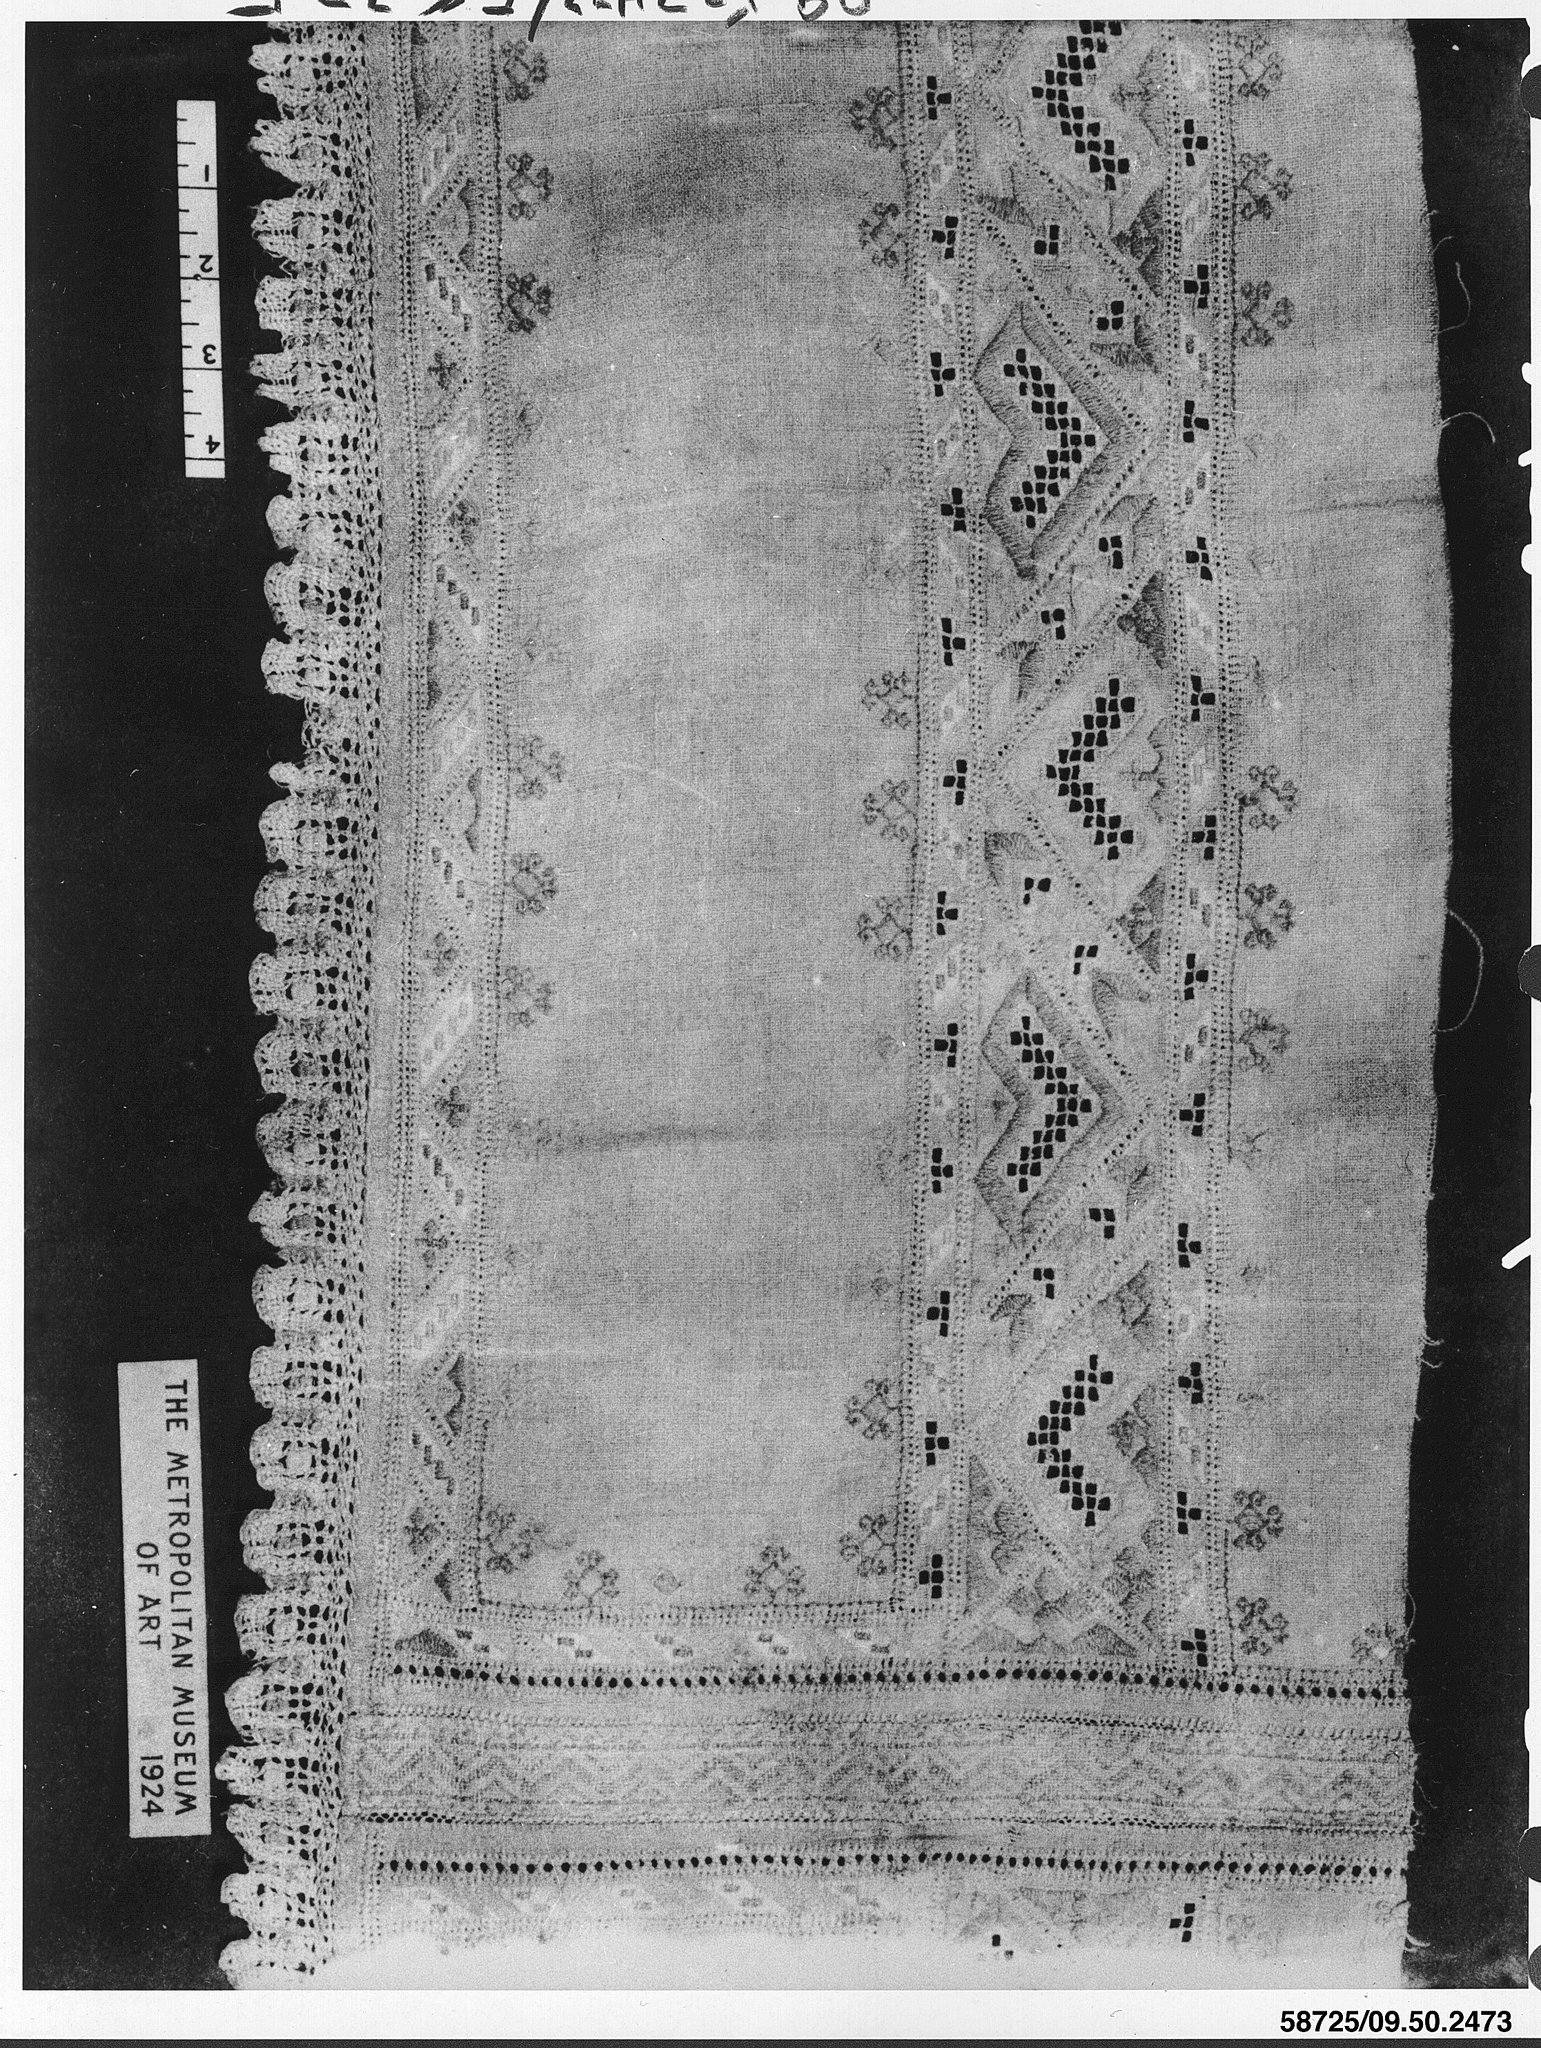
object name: bed valance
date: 1701-1800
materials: linen